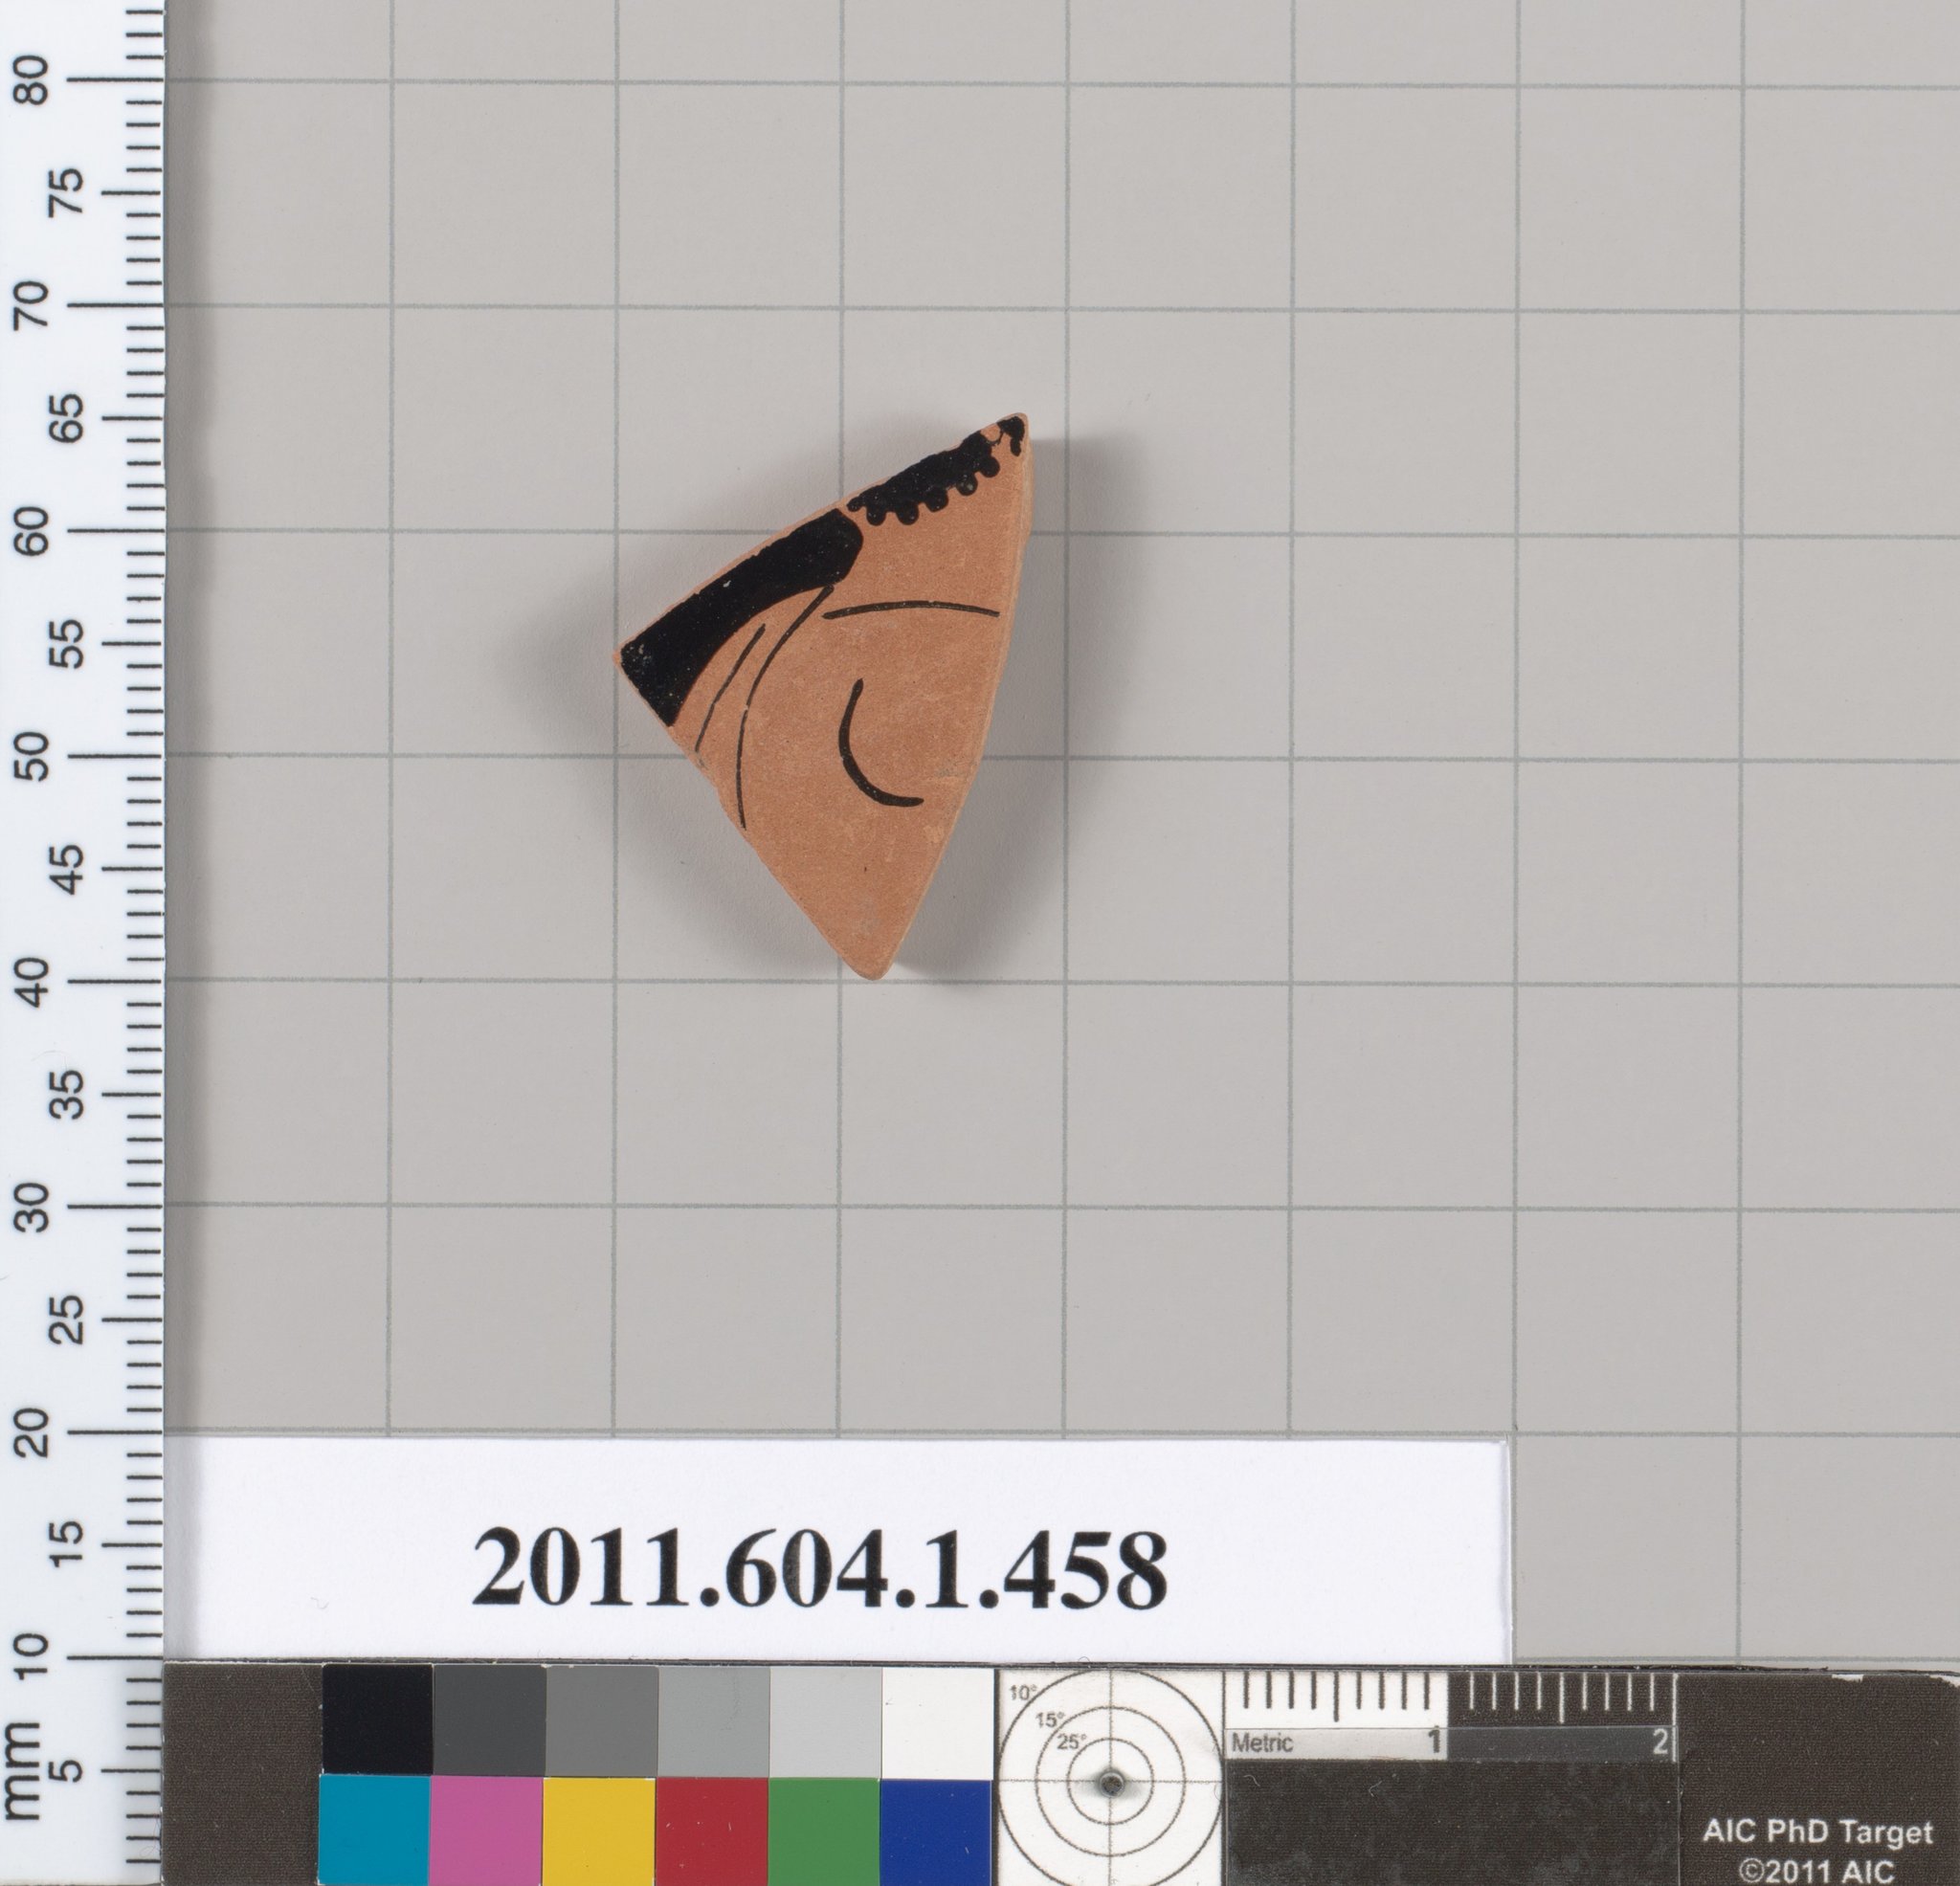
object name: kylix fragment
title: Terracotta fragment of a kylix (drinking cup)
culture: greek, attic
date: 475-451 BCE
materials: terracotta